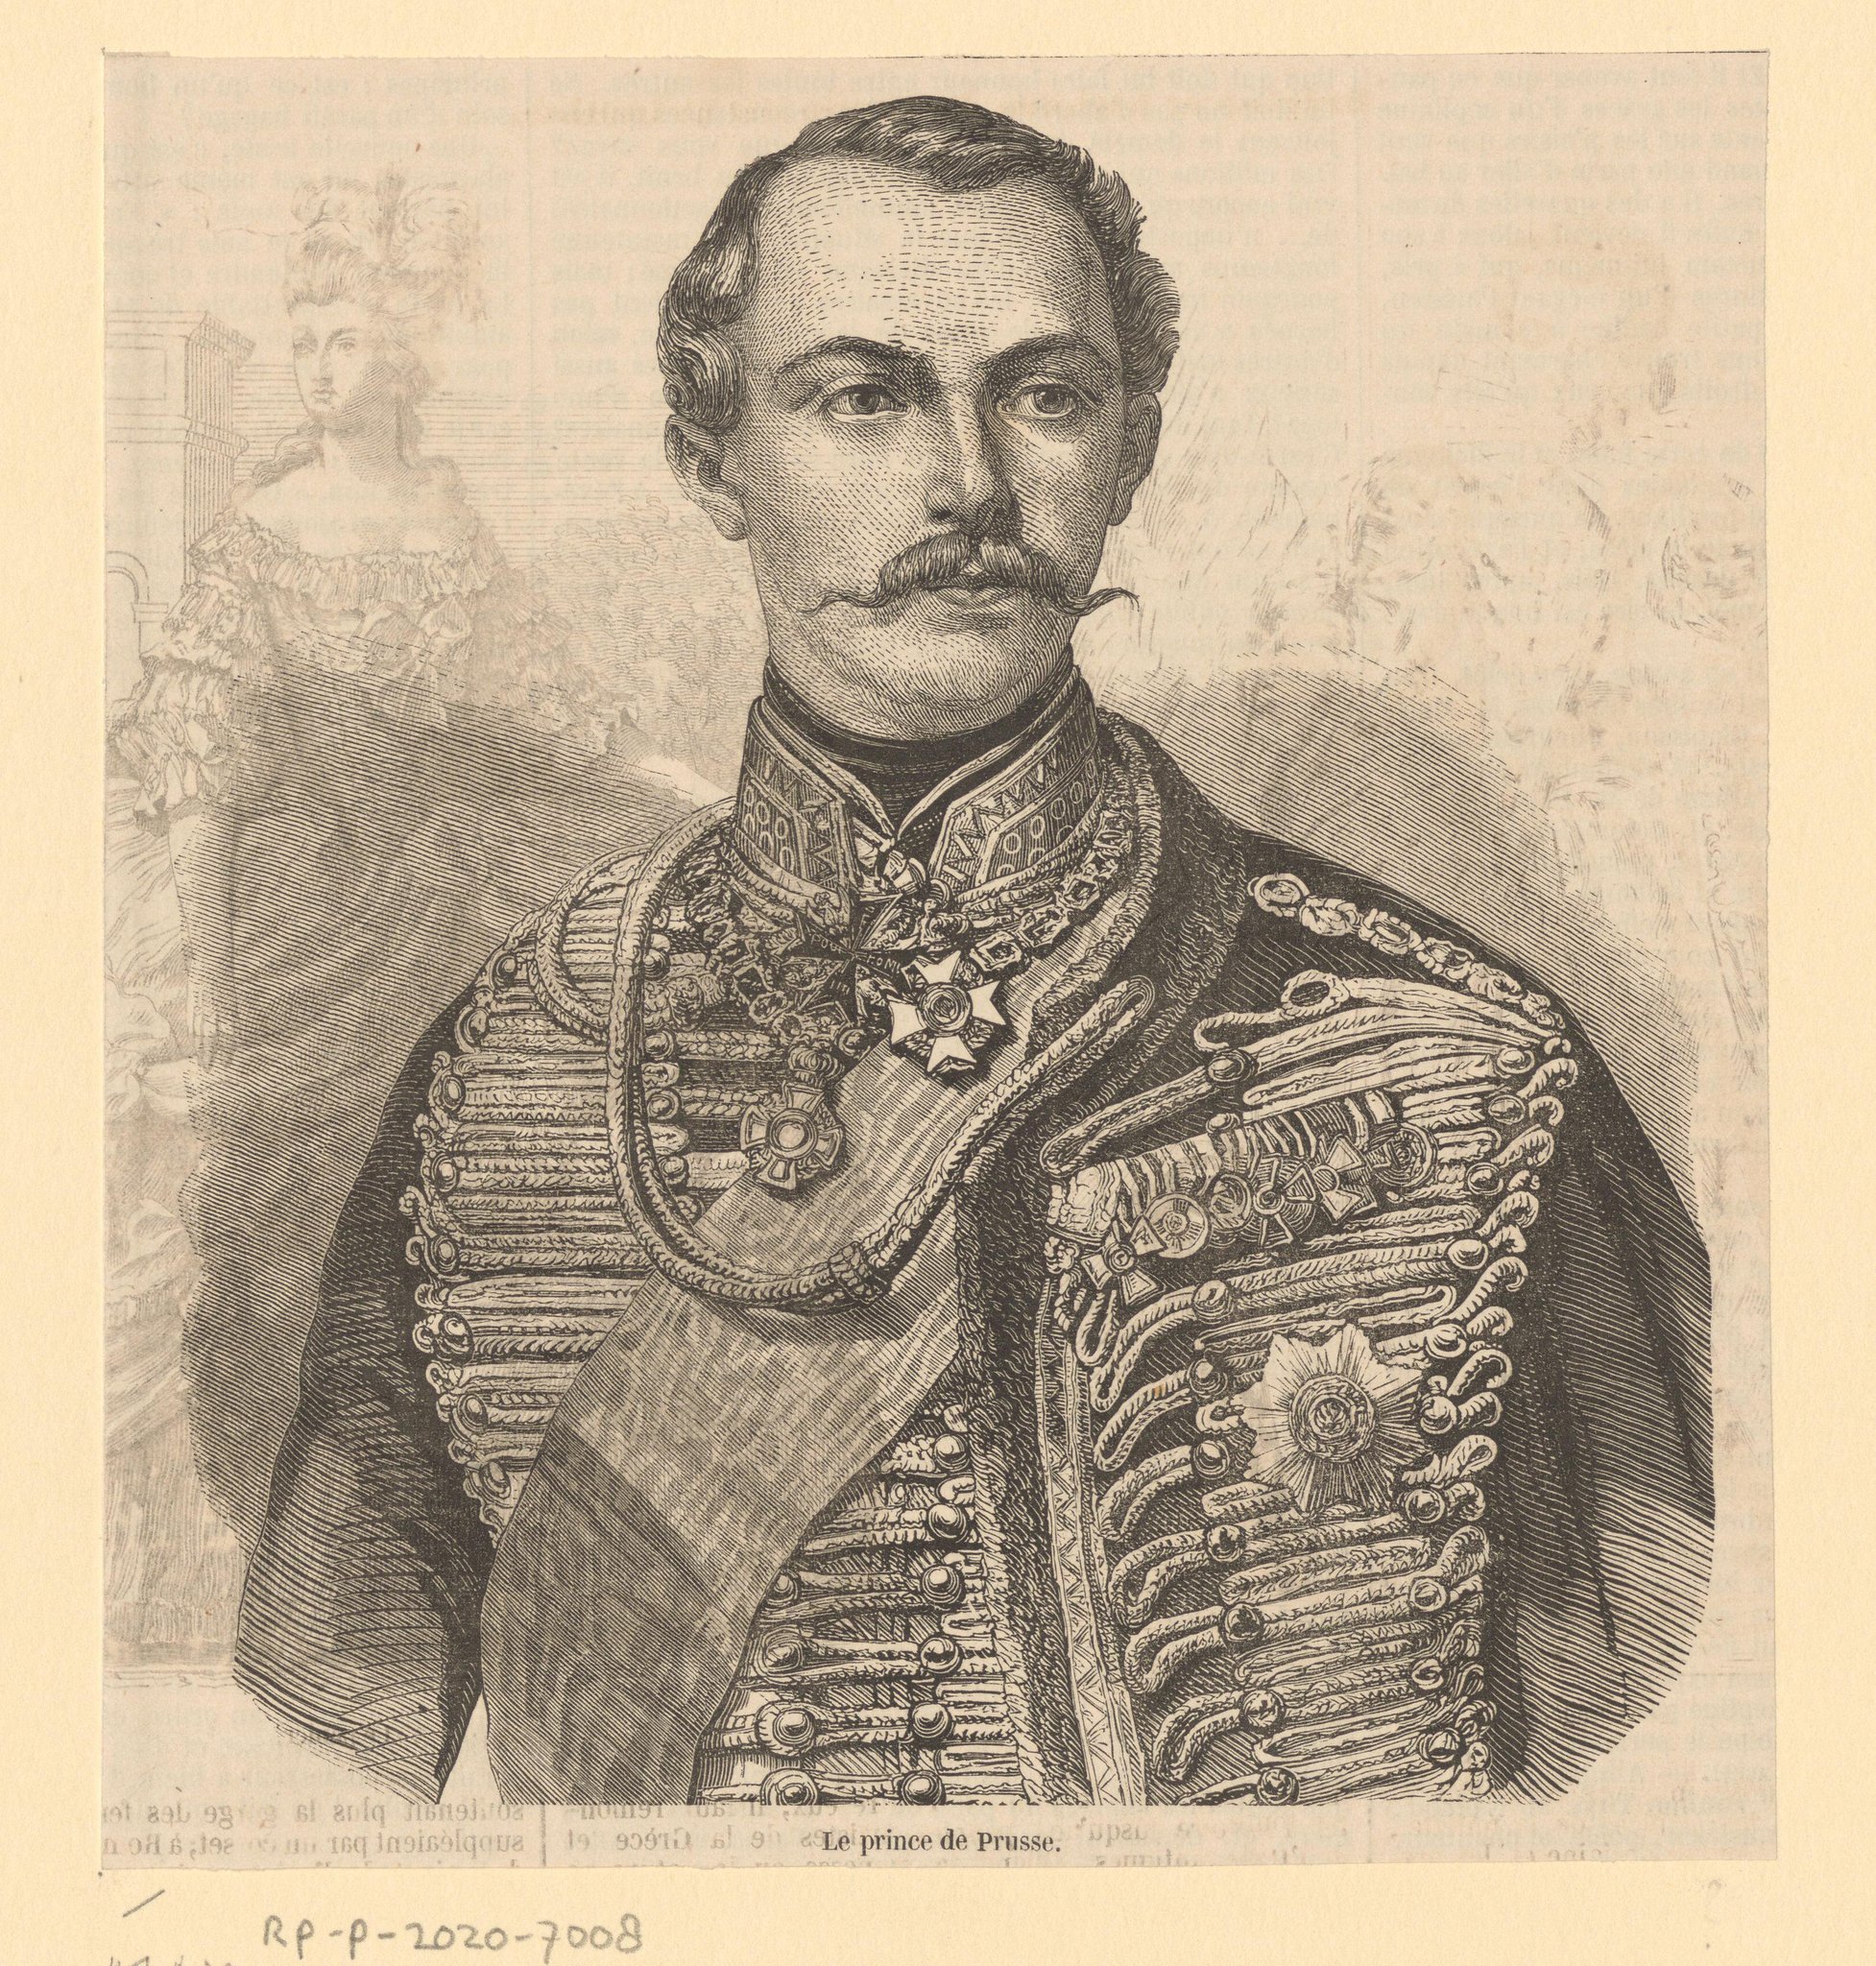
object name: print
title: Portret van Frederik Karel van Pruisen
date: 1856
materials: paper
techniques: printmaking, letterpress printing, engraving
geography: paris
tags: berlin, prince, historical persons, (military) uniforms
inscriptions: inscription: ‘J.A. Marc’, stamp: ‘L'Illustration 27 Dec. 1856’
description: Prent uit: L'Illustration 28 (1856), nr. 722, 27 december 1856, p. 404.